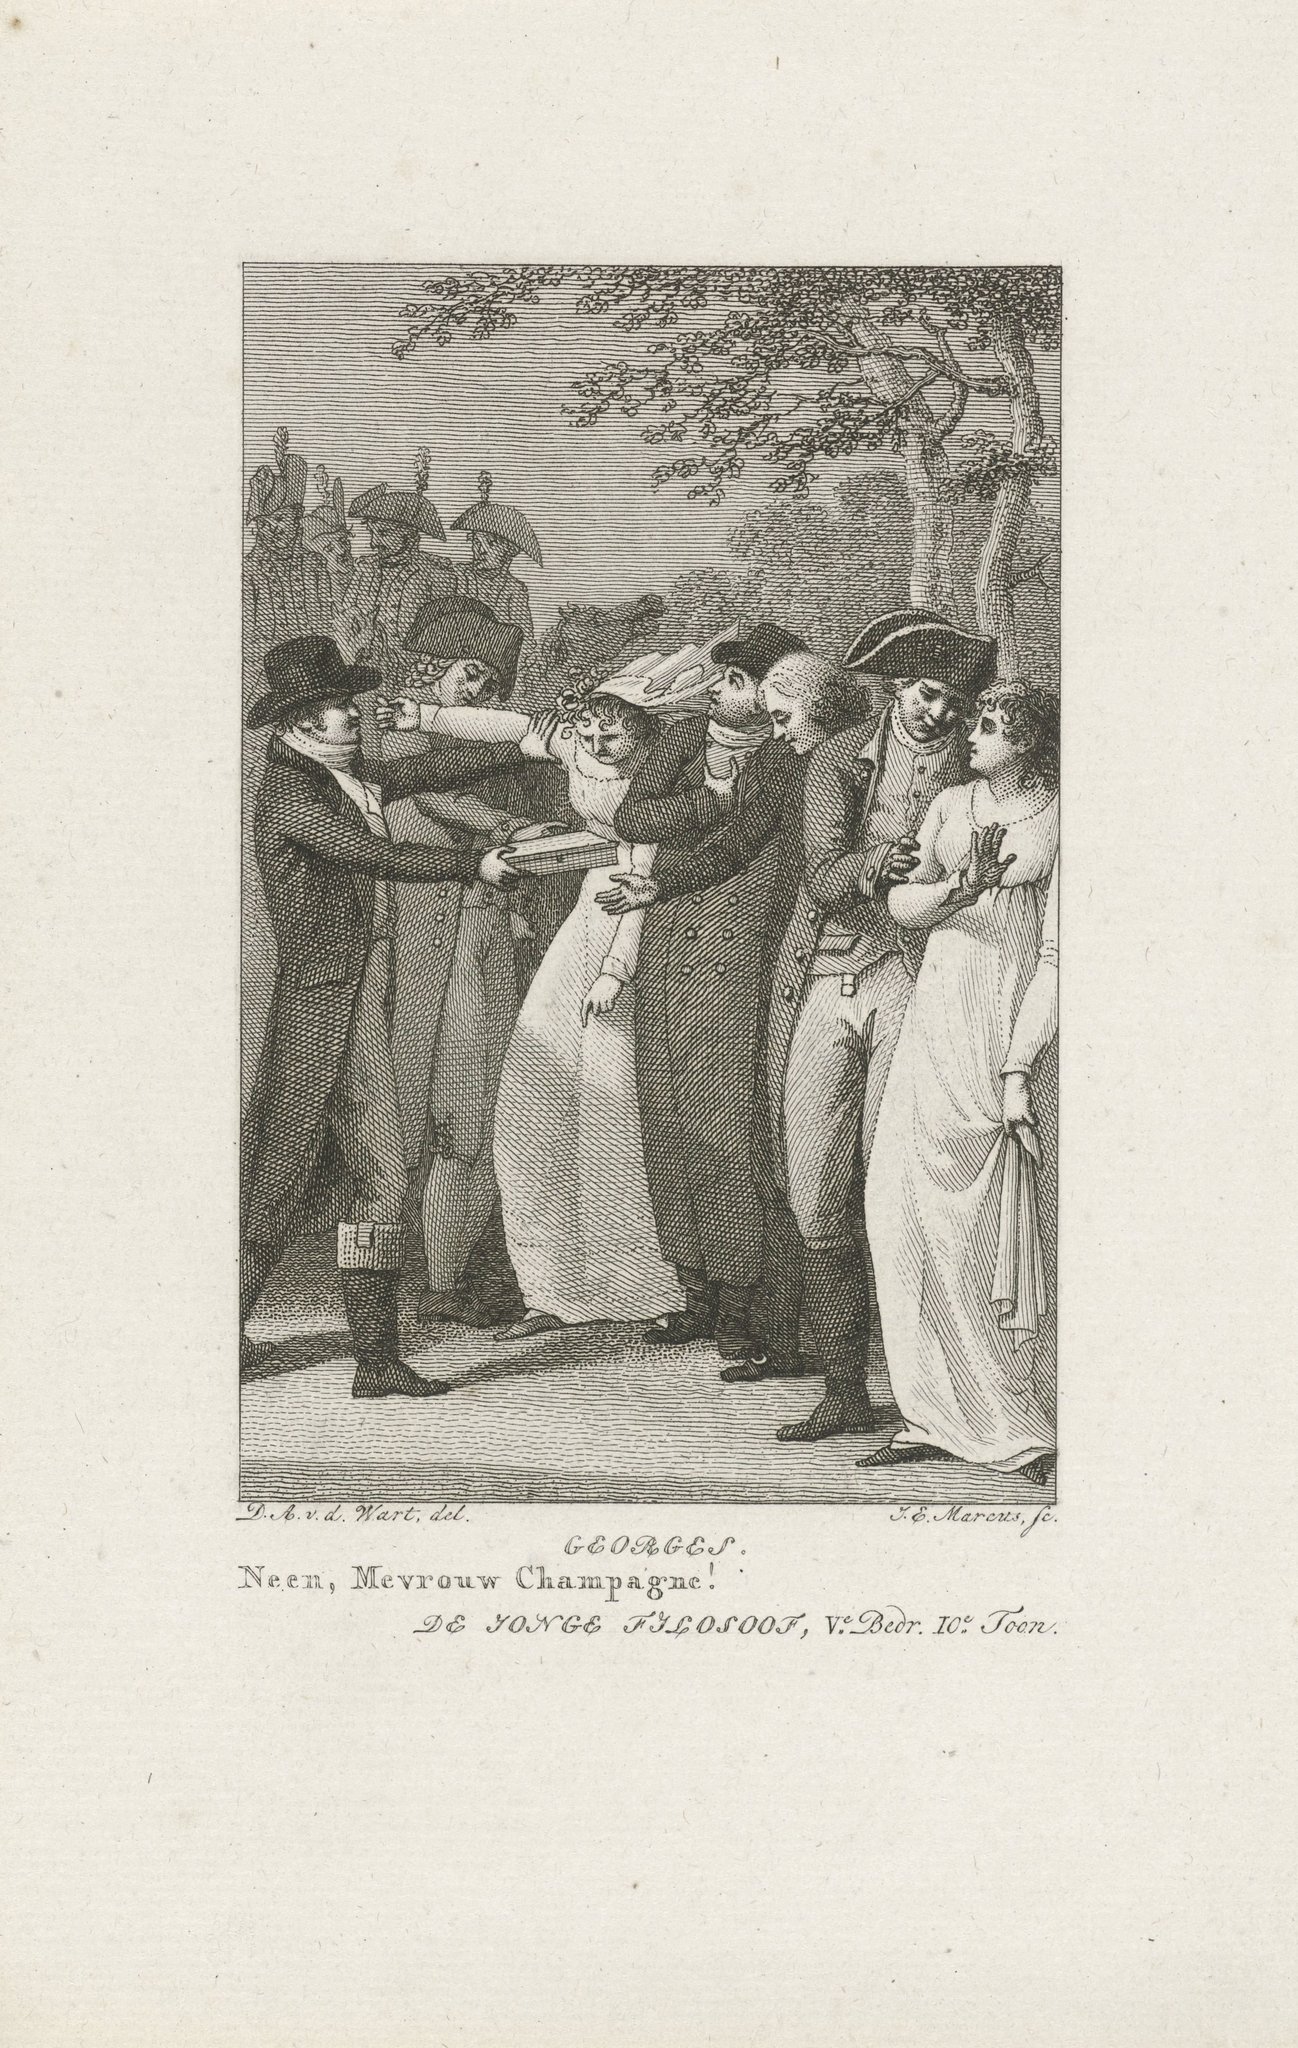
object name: book illustration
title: Georges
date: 1803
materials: paper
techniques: etching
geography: amsterdam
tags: quarrel, argument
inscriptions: collector's mark: Lugt 2228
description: Vercshillende mannen en vrouwen, in het midden een vrouw die tegengehouden lijkt te worden. Links geeft een man een kistje aan een andere figuur. Rechtsonder gemerkt: Ve Bedr. 10e Toon.